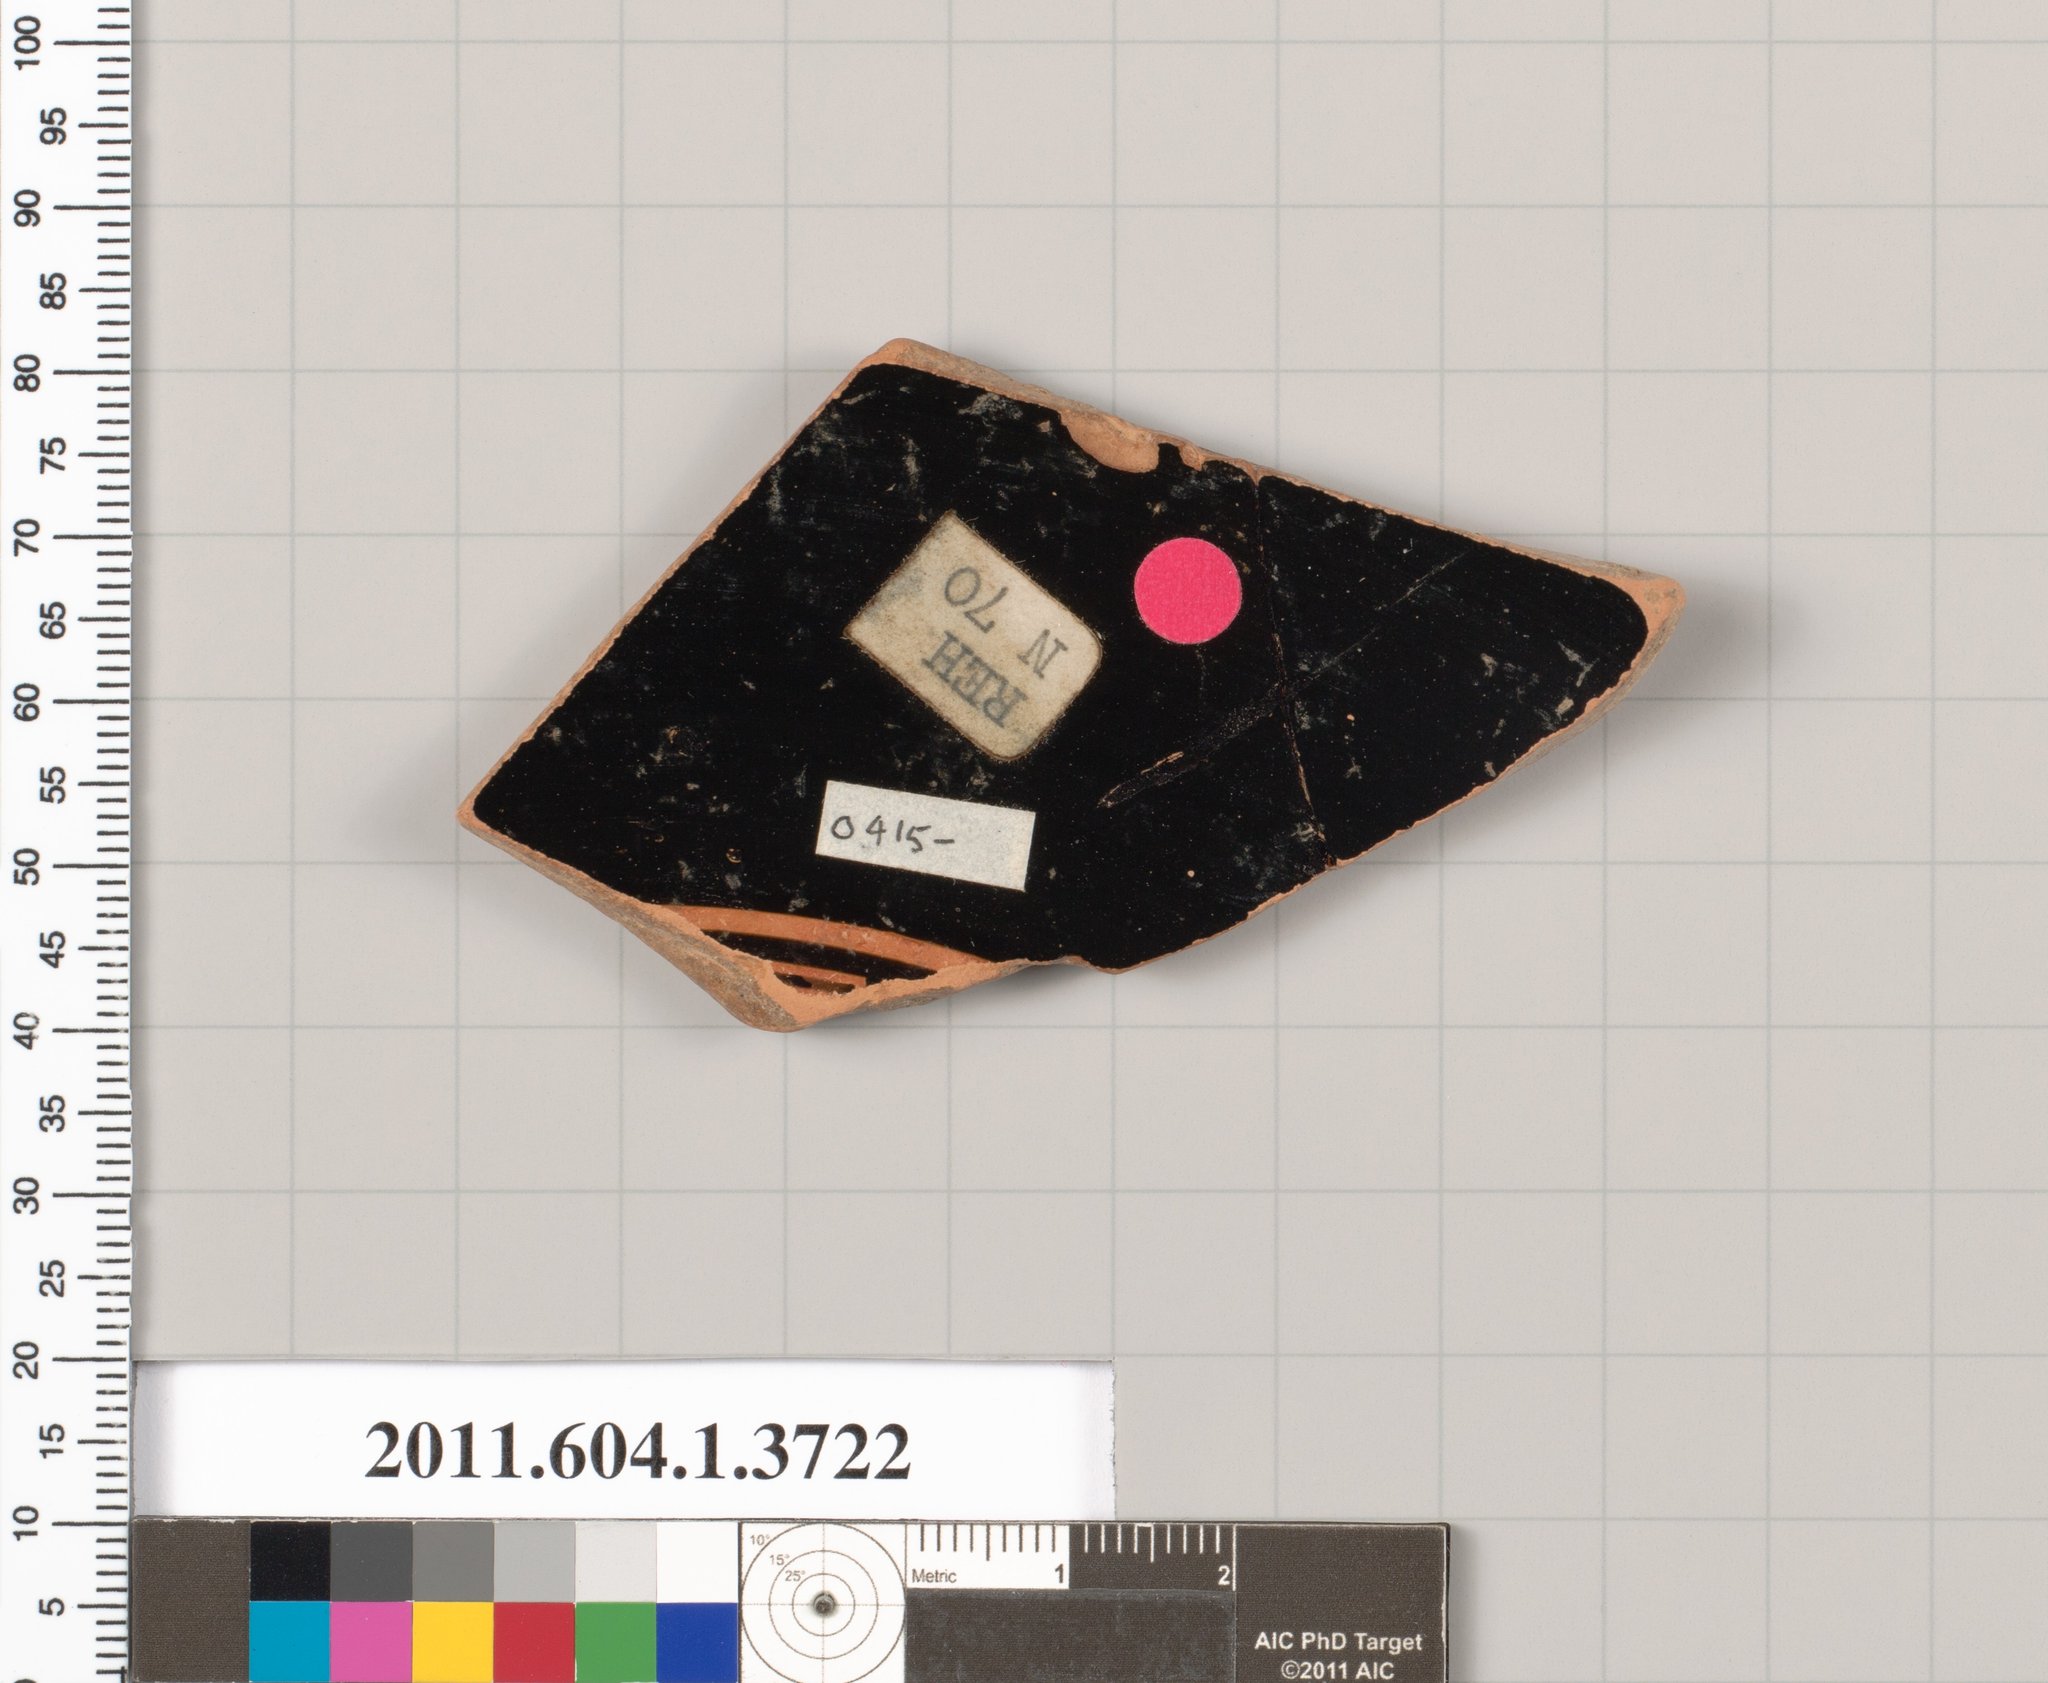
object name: kylix fragment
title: Terracotta fragment of a kylix (drinking cup)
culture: greek, attic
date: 475-451 BCE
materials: terracotta